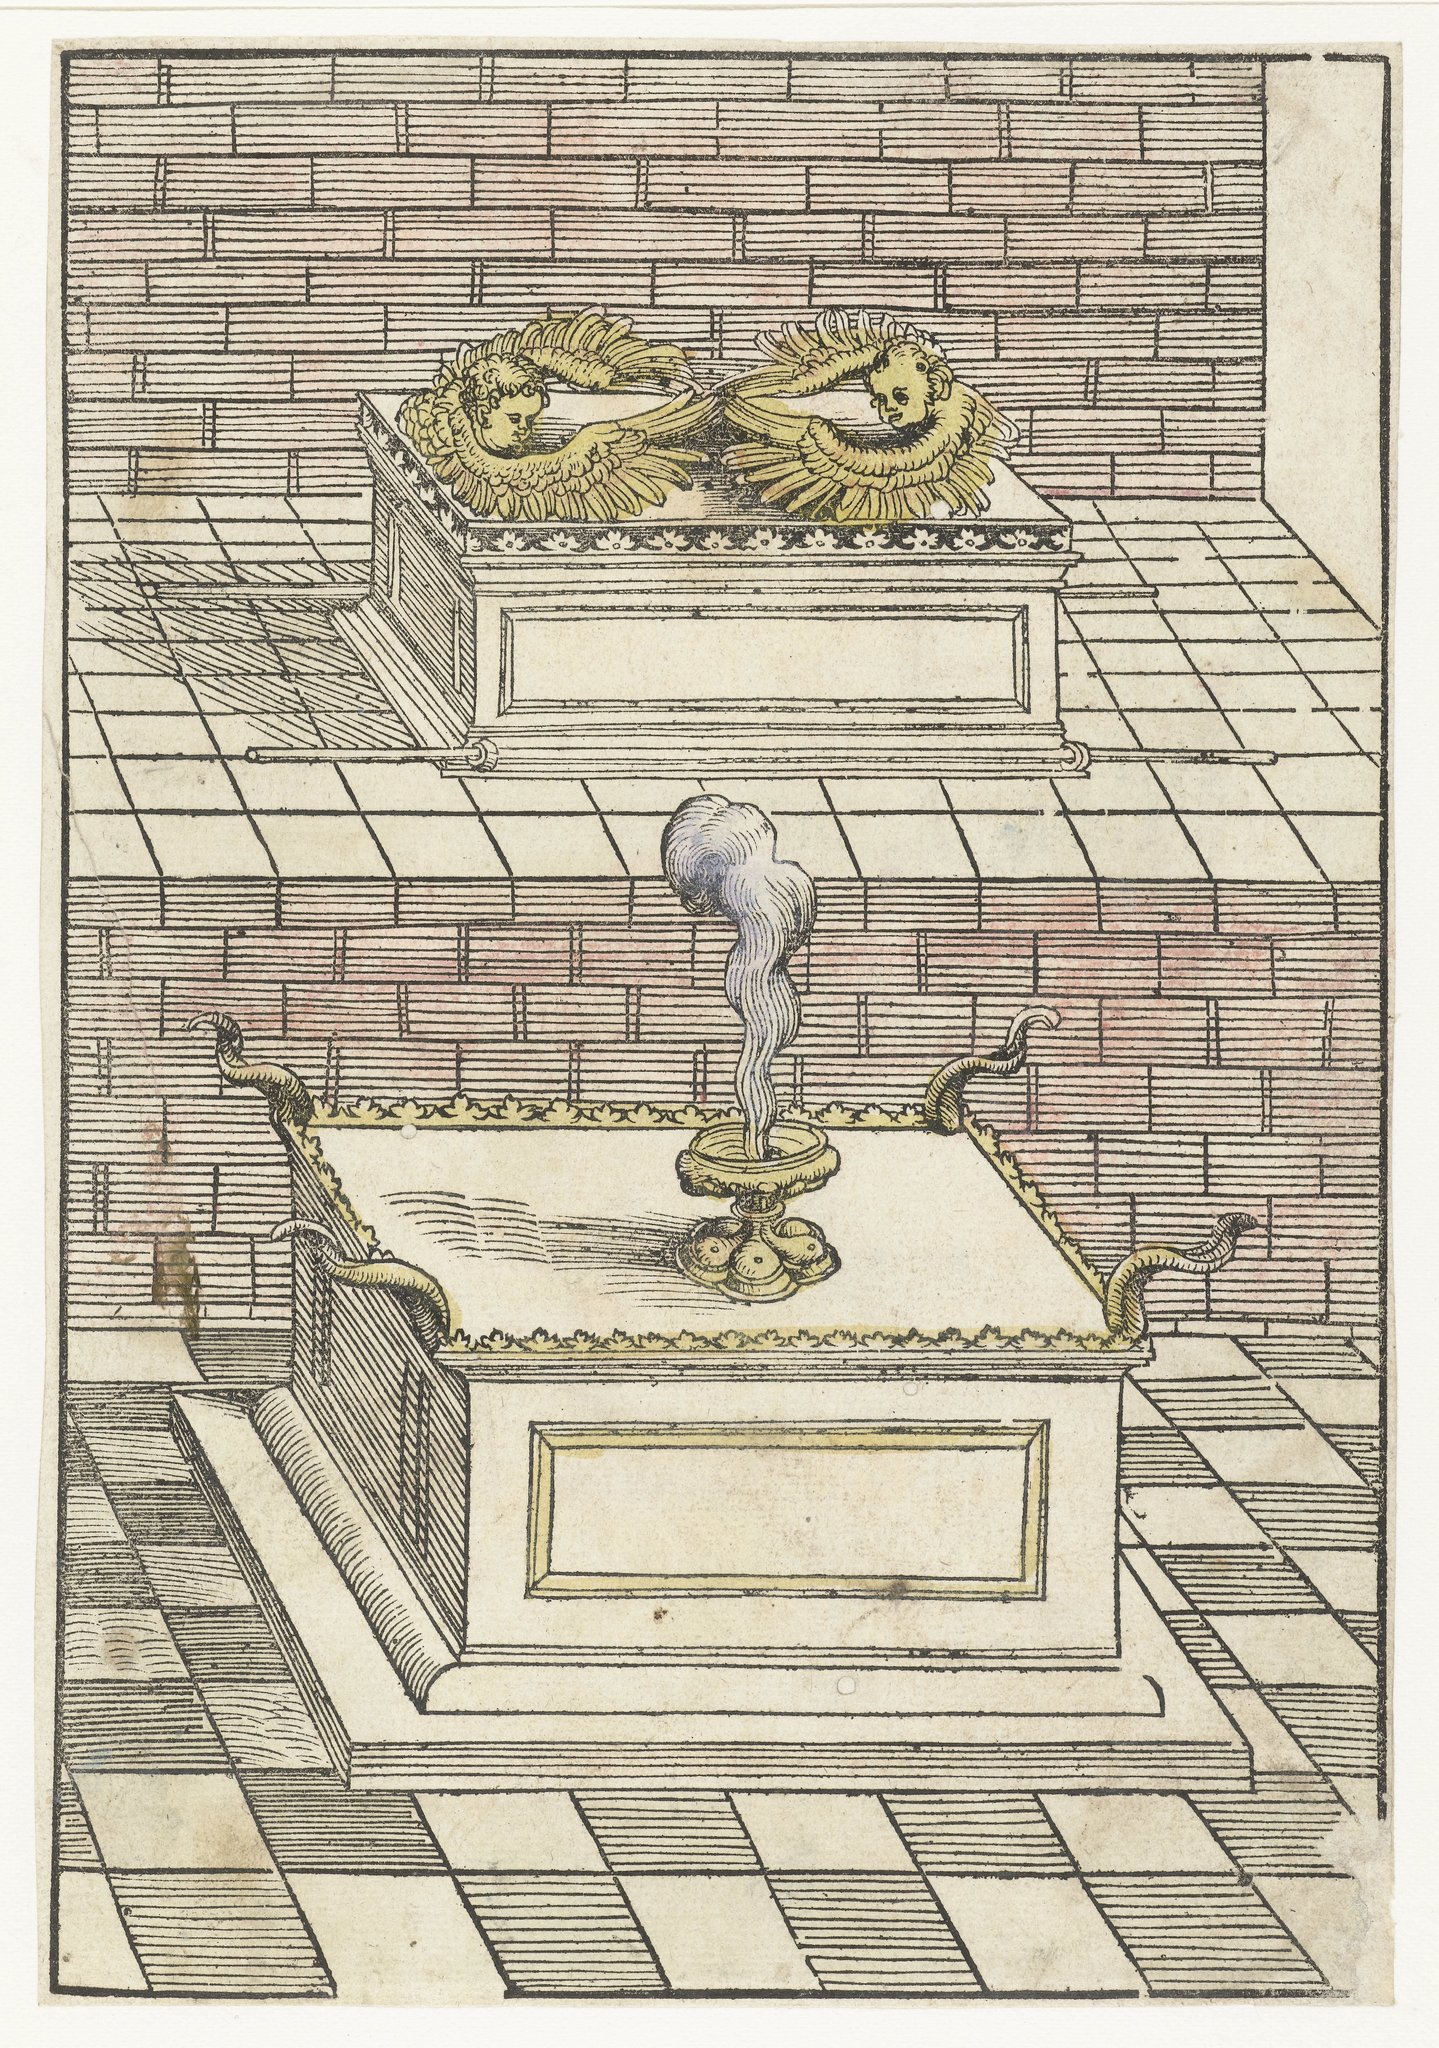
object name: print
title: Ark van het verbond en reukofferaltaar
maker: lucas cranach (i)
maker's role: draughtsman, print maker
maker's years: 1472-1553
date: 1523-1526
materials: paper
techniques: hand coloring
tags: ark of the covenant ~ jewish religion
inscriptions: collector's mark: Lugt 2233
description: Houtblokken gebruikt voor: Das Alte Testament deutsch, deel I, Wittenberg 1523 (eerste druk) maar ook later (tot 1526) verschenen drukken waarin de houtblokken werden gebruikt. De serie van elf boekillustraties in de collectie van het RMA heeft blanco verso zijden, dit is kenmerkend voor deze uitgaven van Luthers bijbel, zie Koepplin 1974, p. 341.